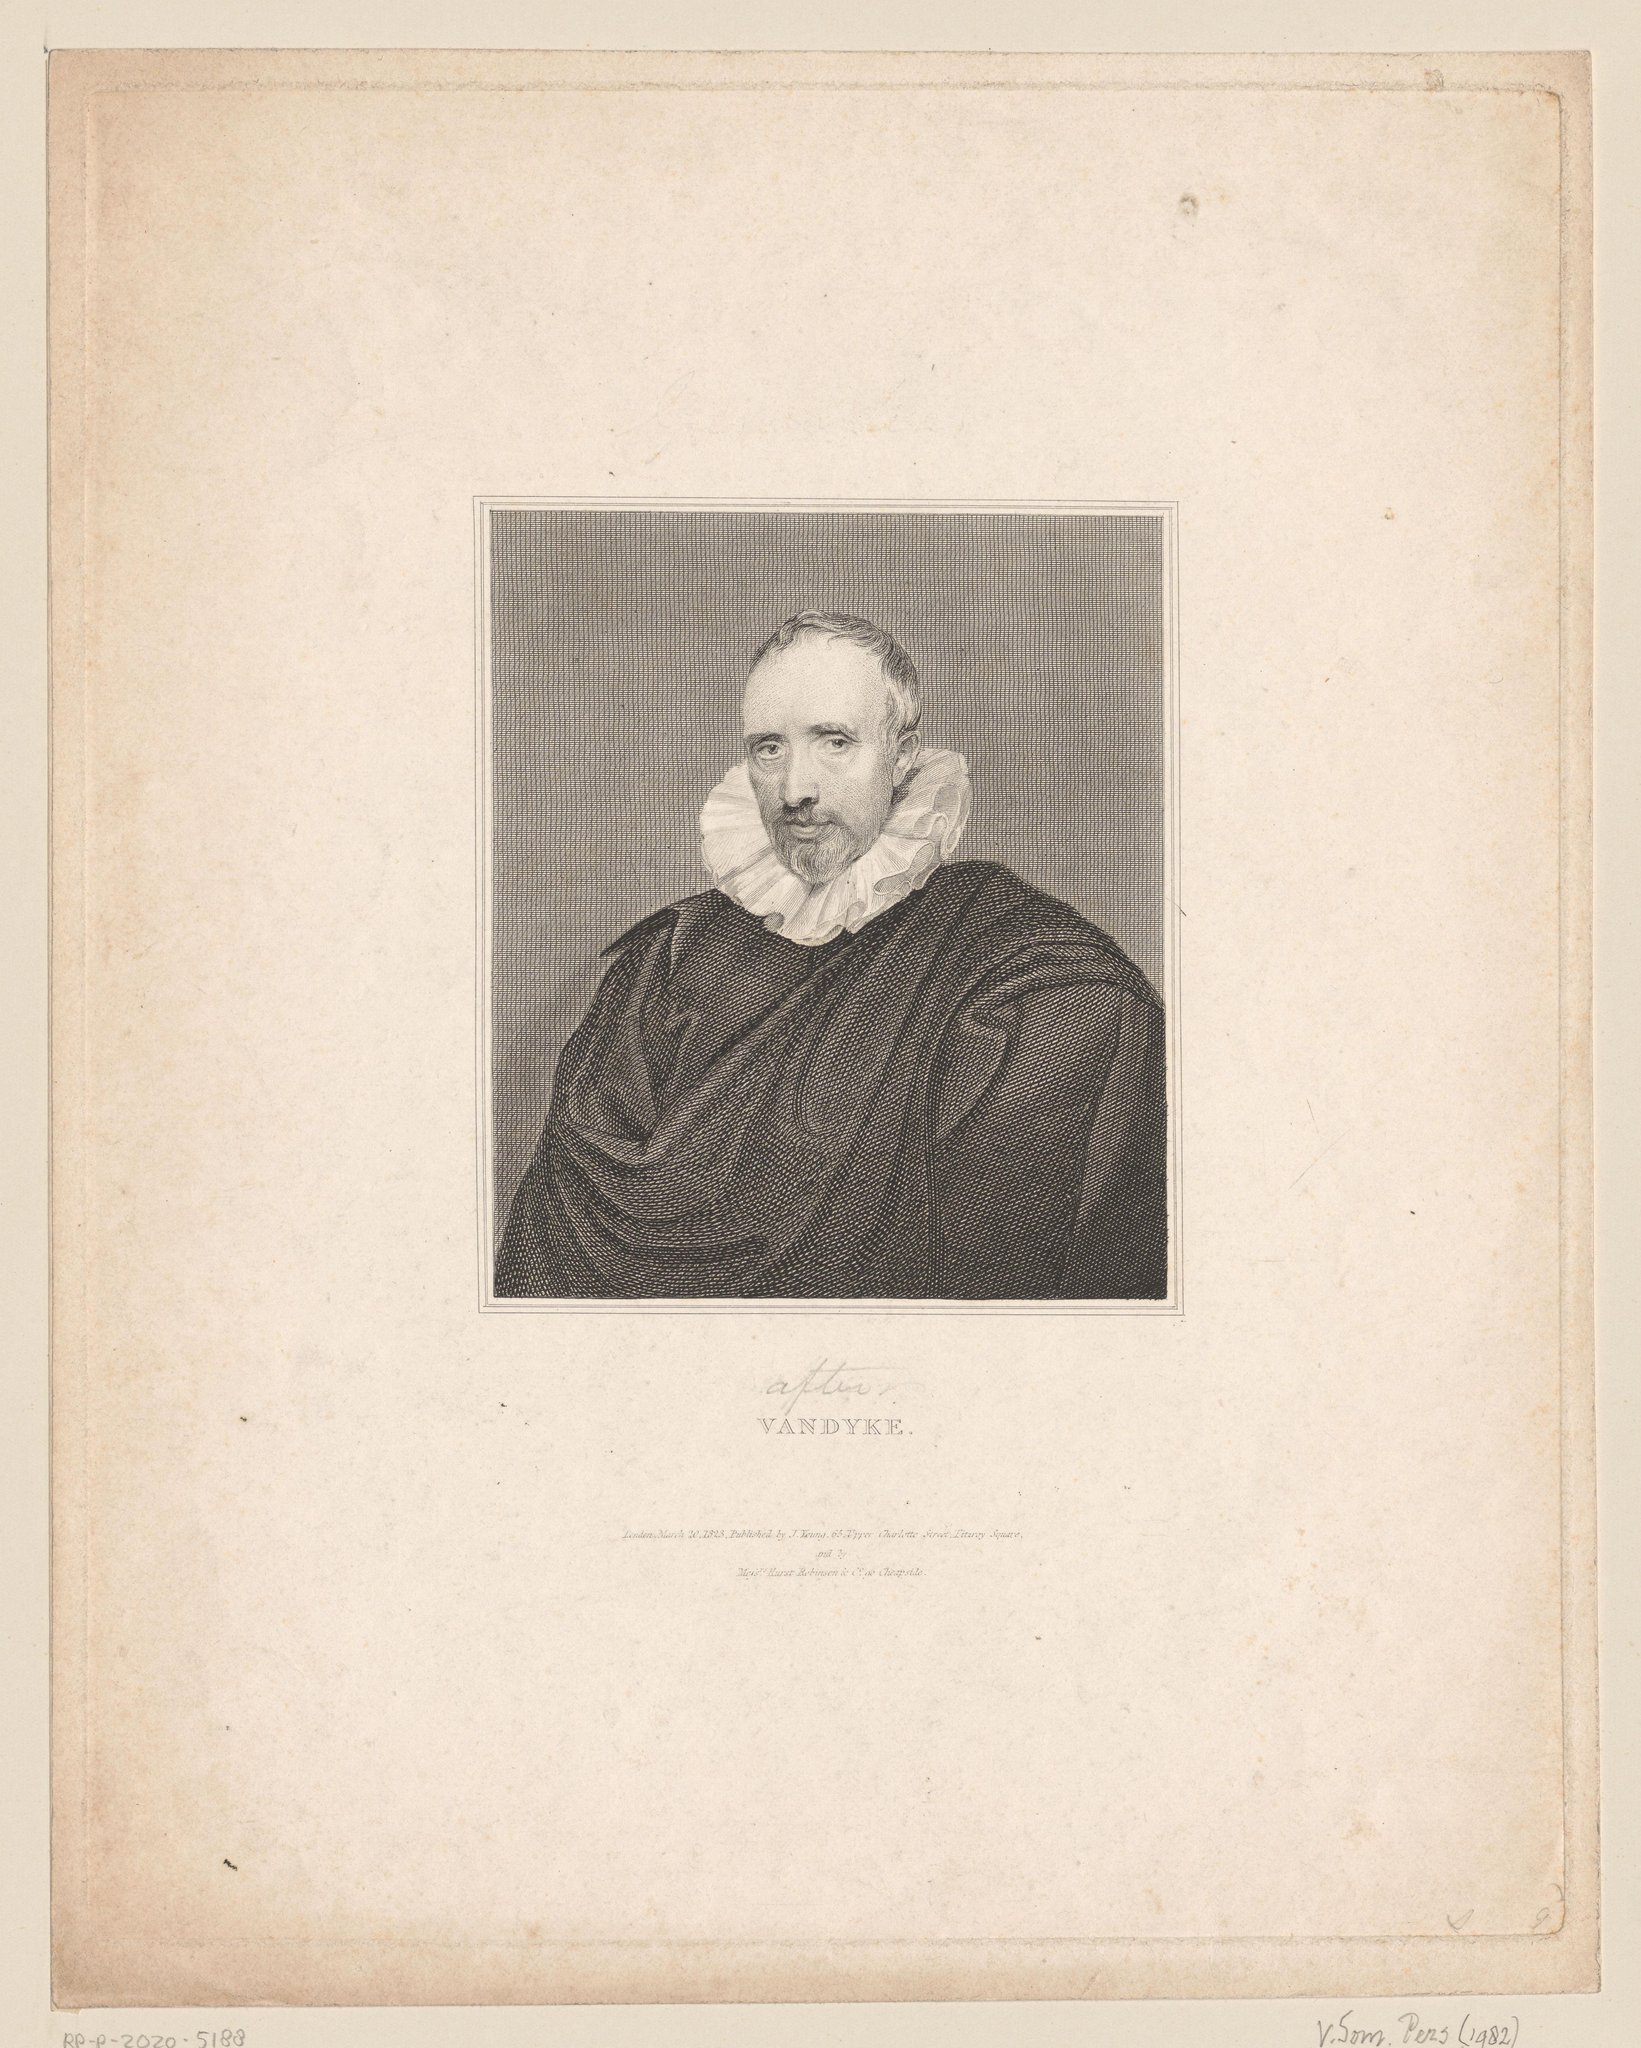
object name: print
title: Portret van Cornelis van der Geest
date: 1823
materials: paper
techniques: engraving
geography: london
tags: cornelis van der geest, historical persons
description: Prent uit: Catalogue of the Celebrated Collection of Pictures of (...) John Julius Angerstein. Londen: John Young and Hurst, Robinson & Co., 1823.